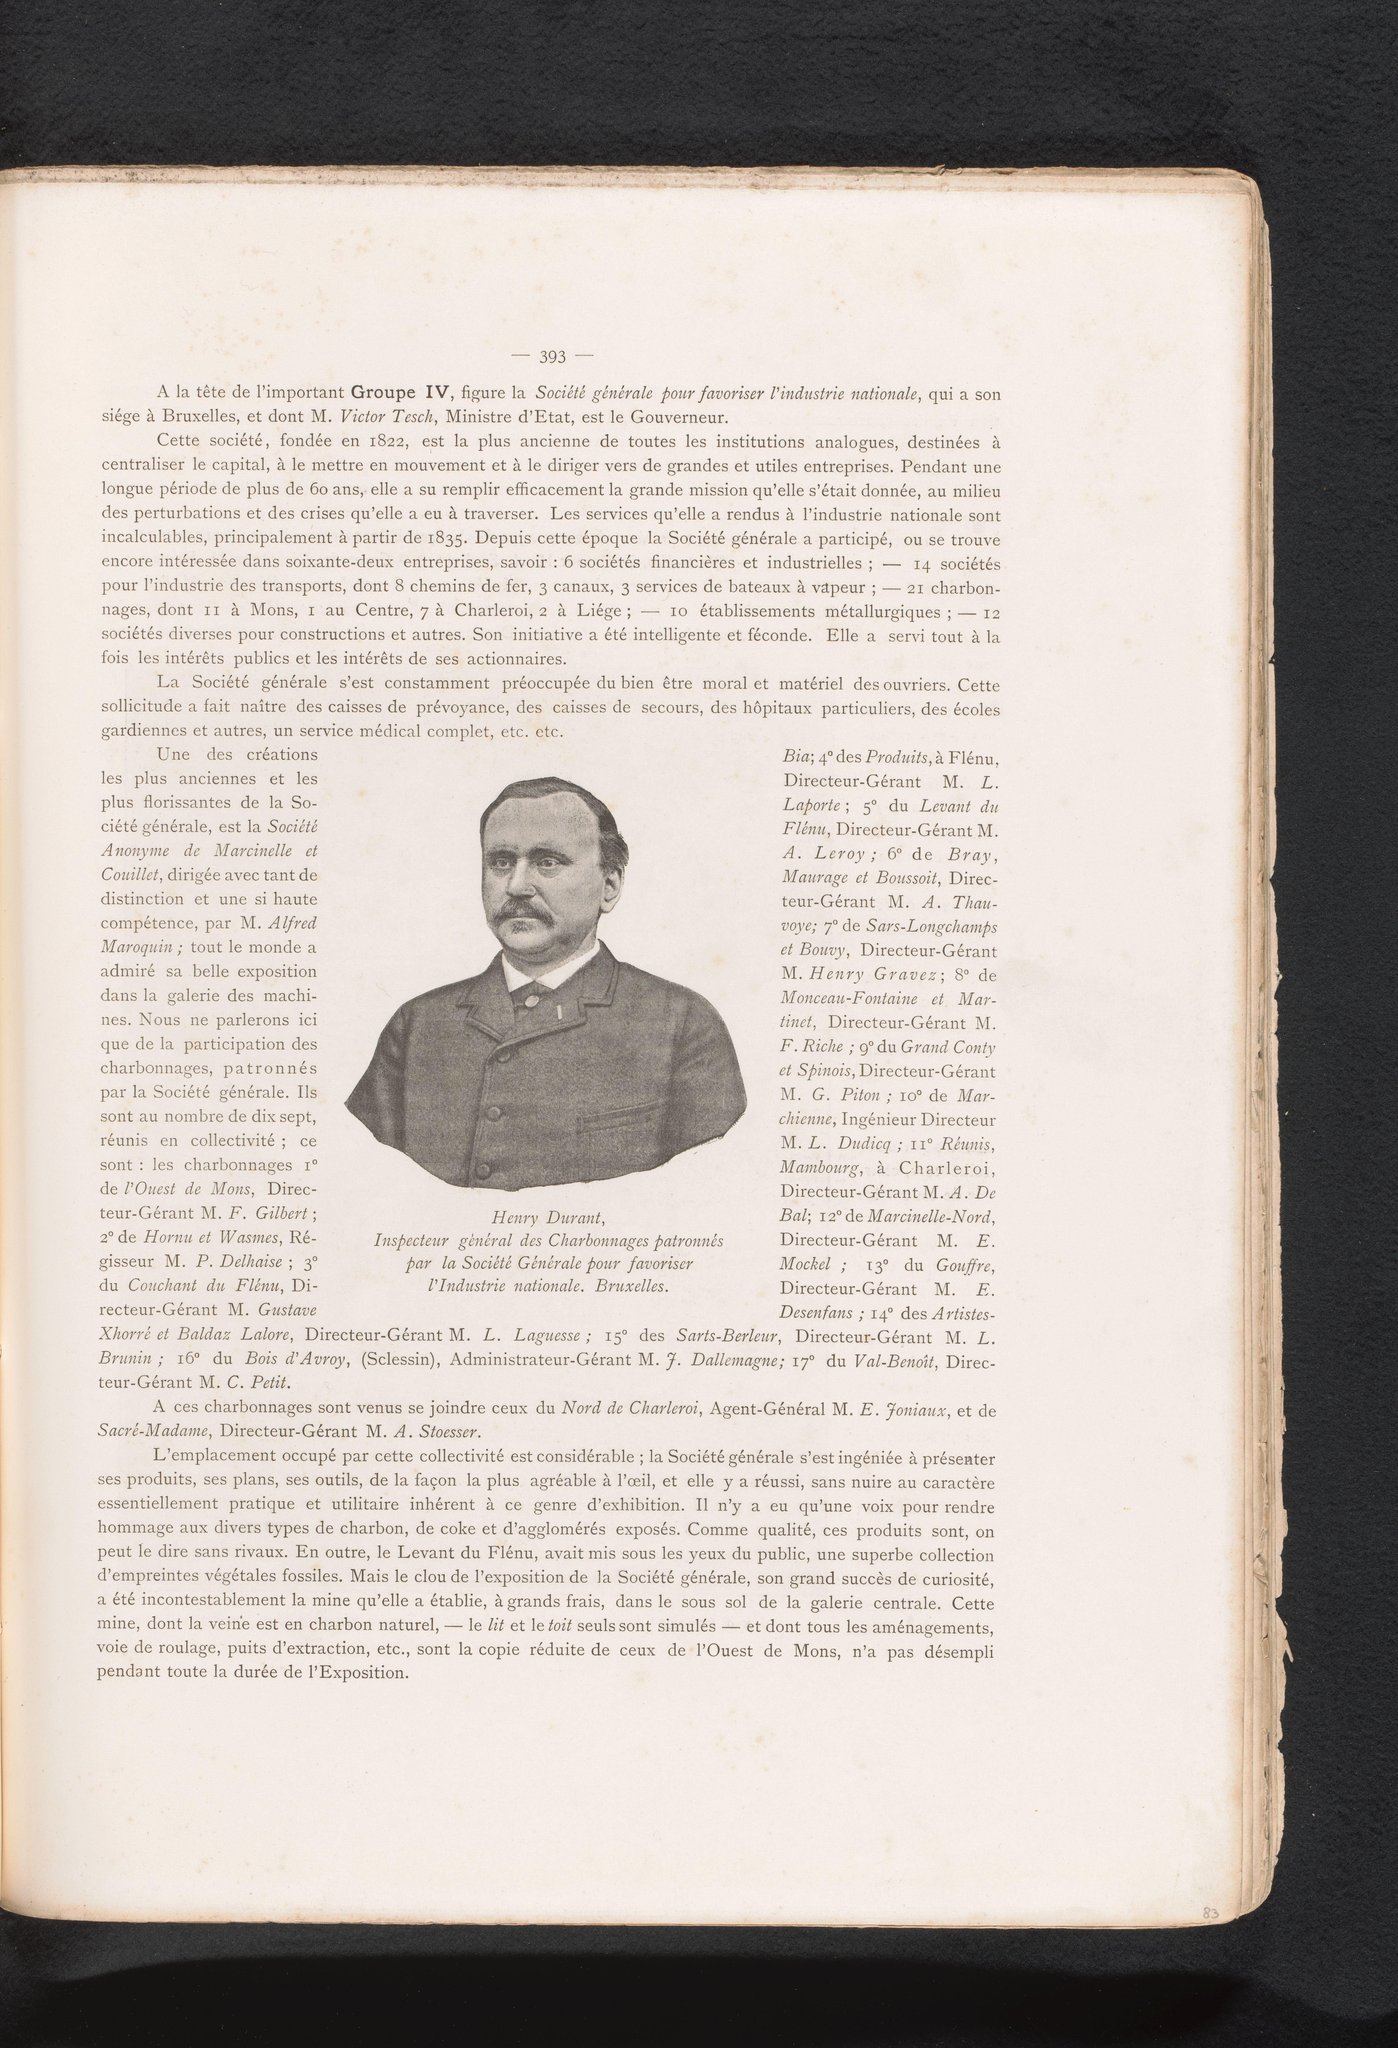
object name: photomechanical print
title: Henry Durant, Inspecteur général des Charbonnages patronnés par la Société Générale pour favoriser l'Industrie nationale. Bruxelles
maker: Anonymous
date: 1880-1885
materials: paper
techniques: autotype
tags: historical persons